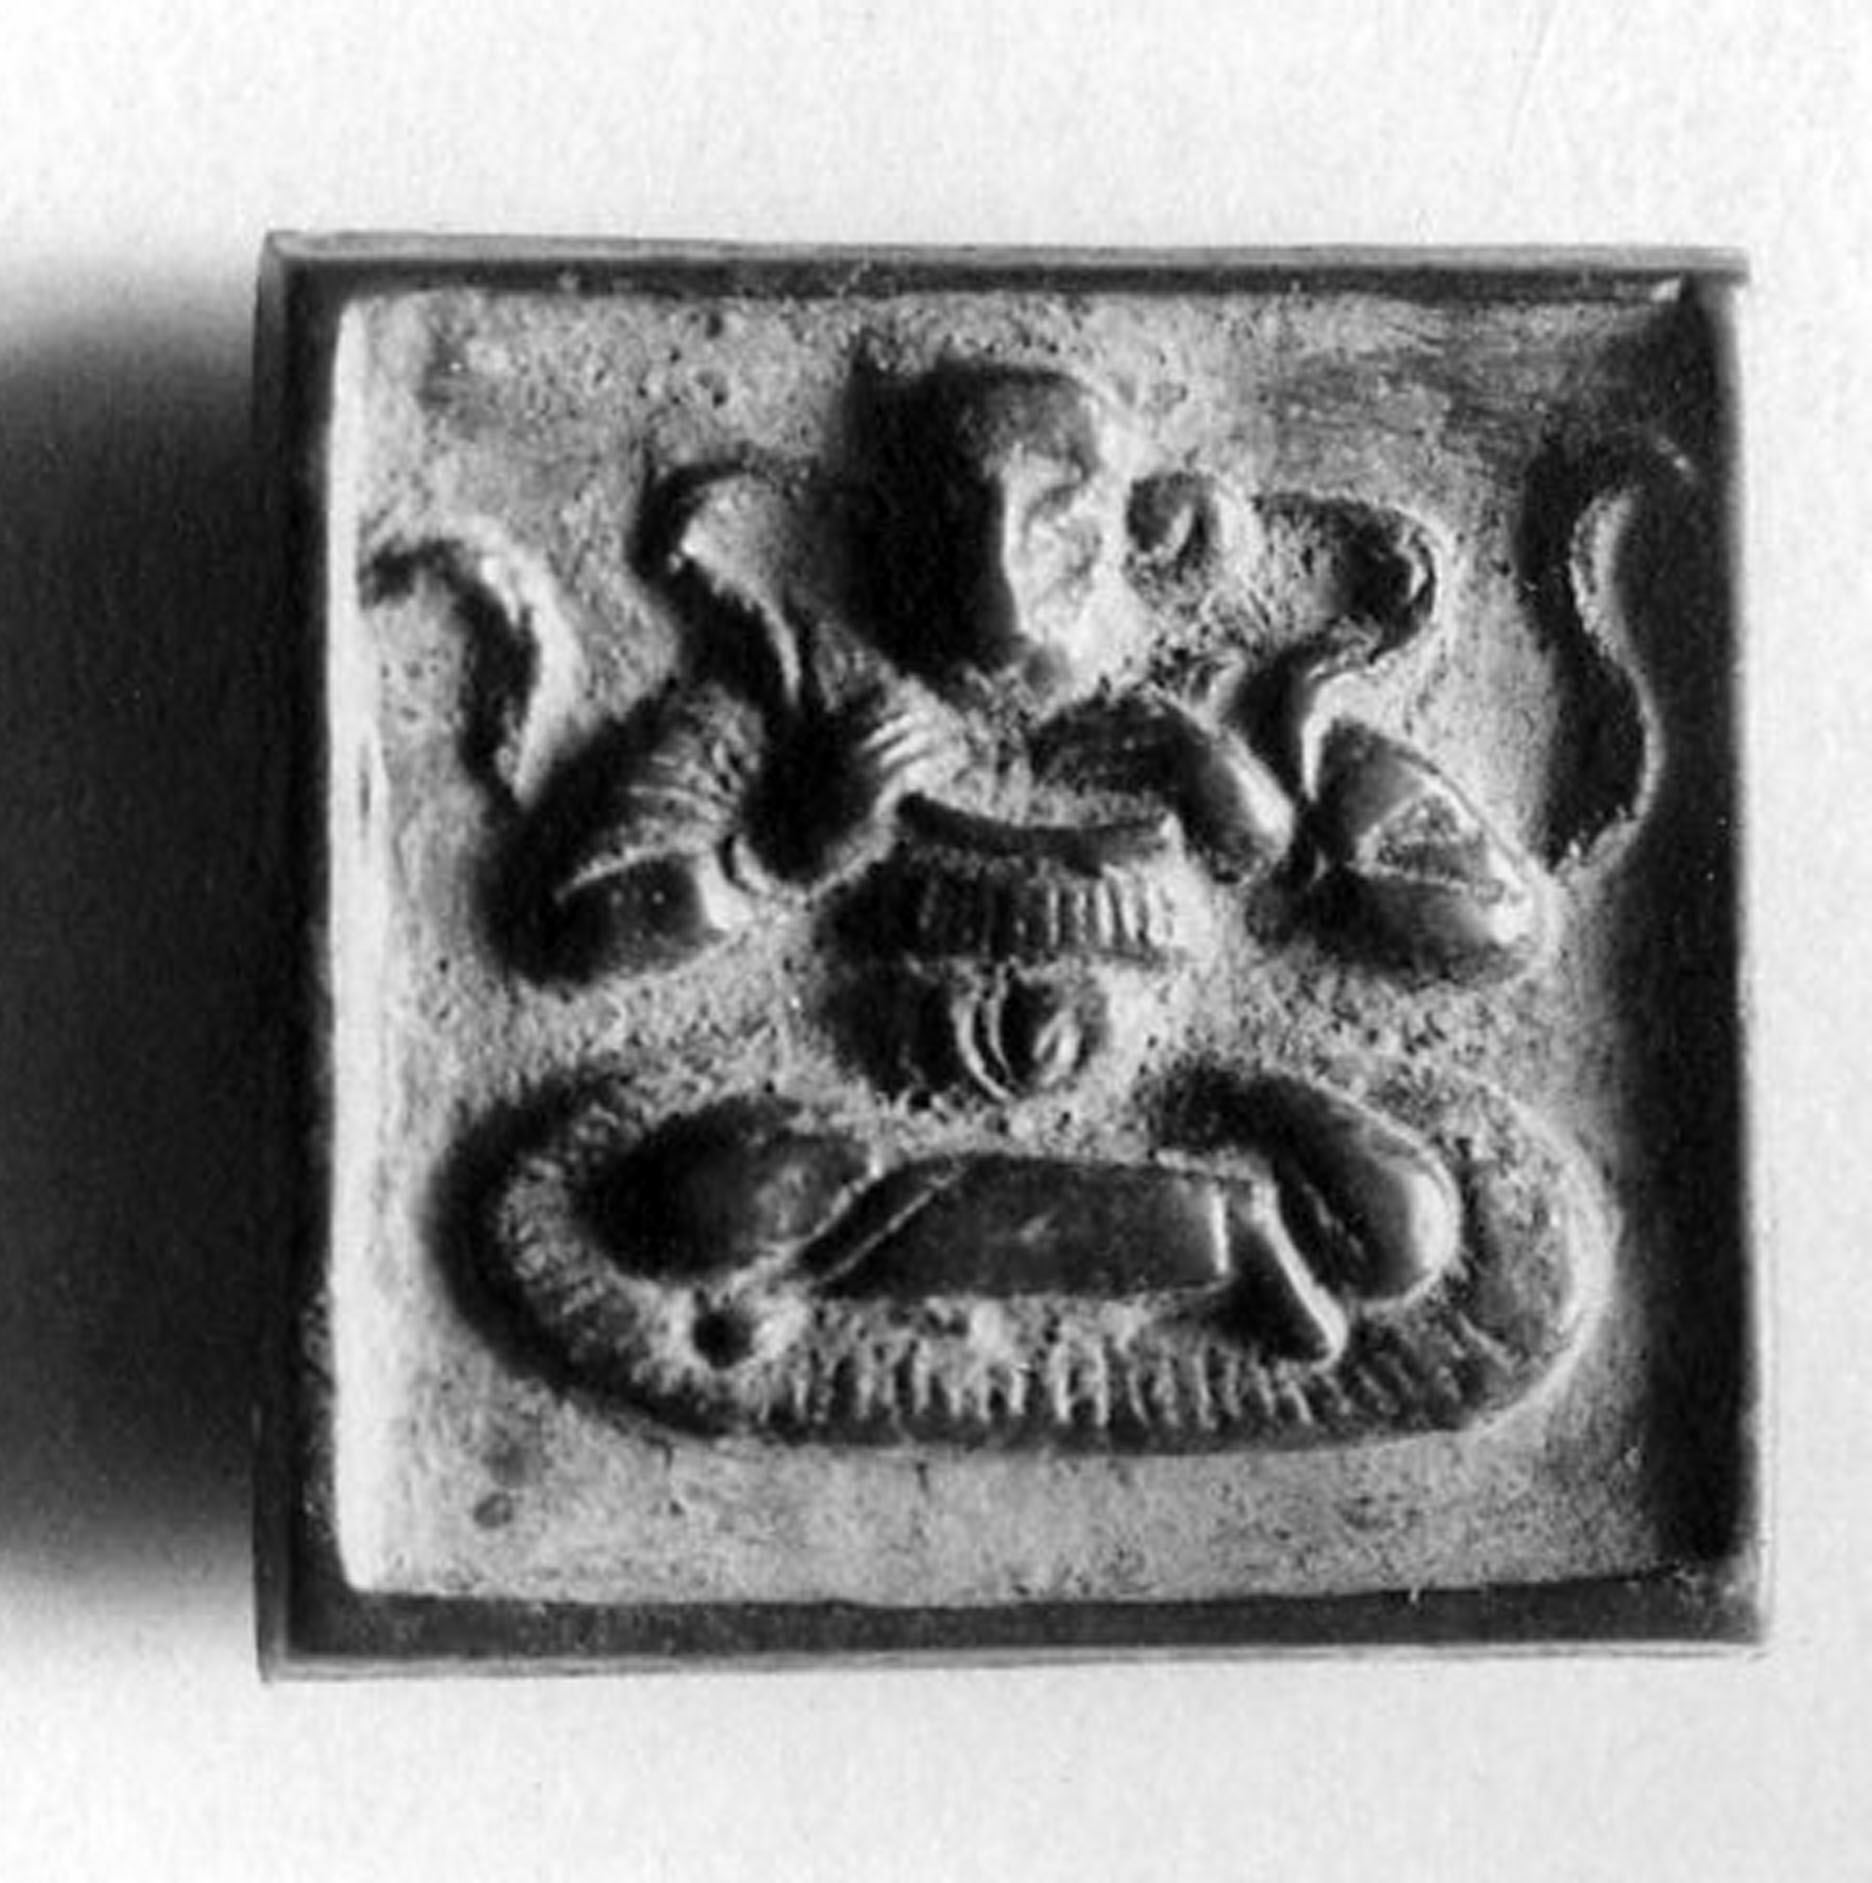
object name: belt plaque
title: Decorative belt plaque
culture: chinese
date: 701-800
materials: gilt bronze